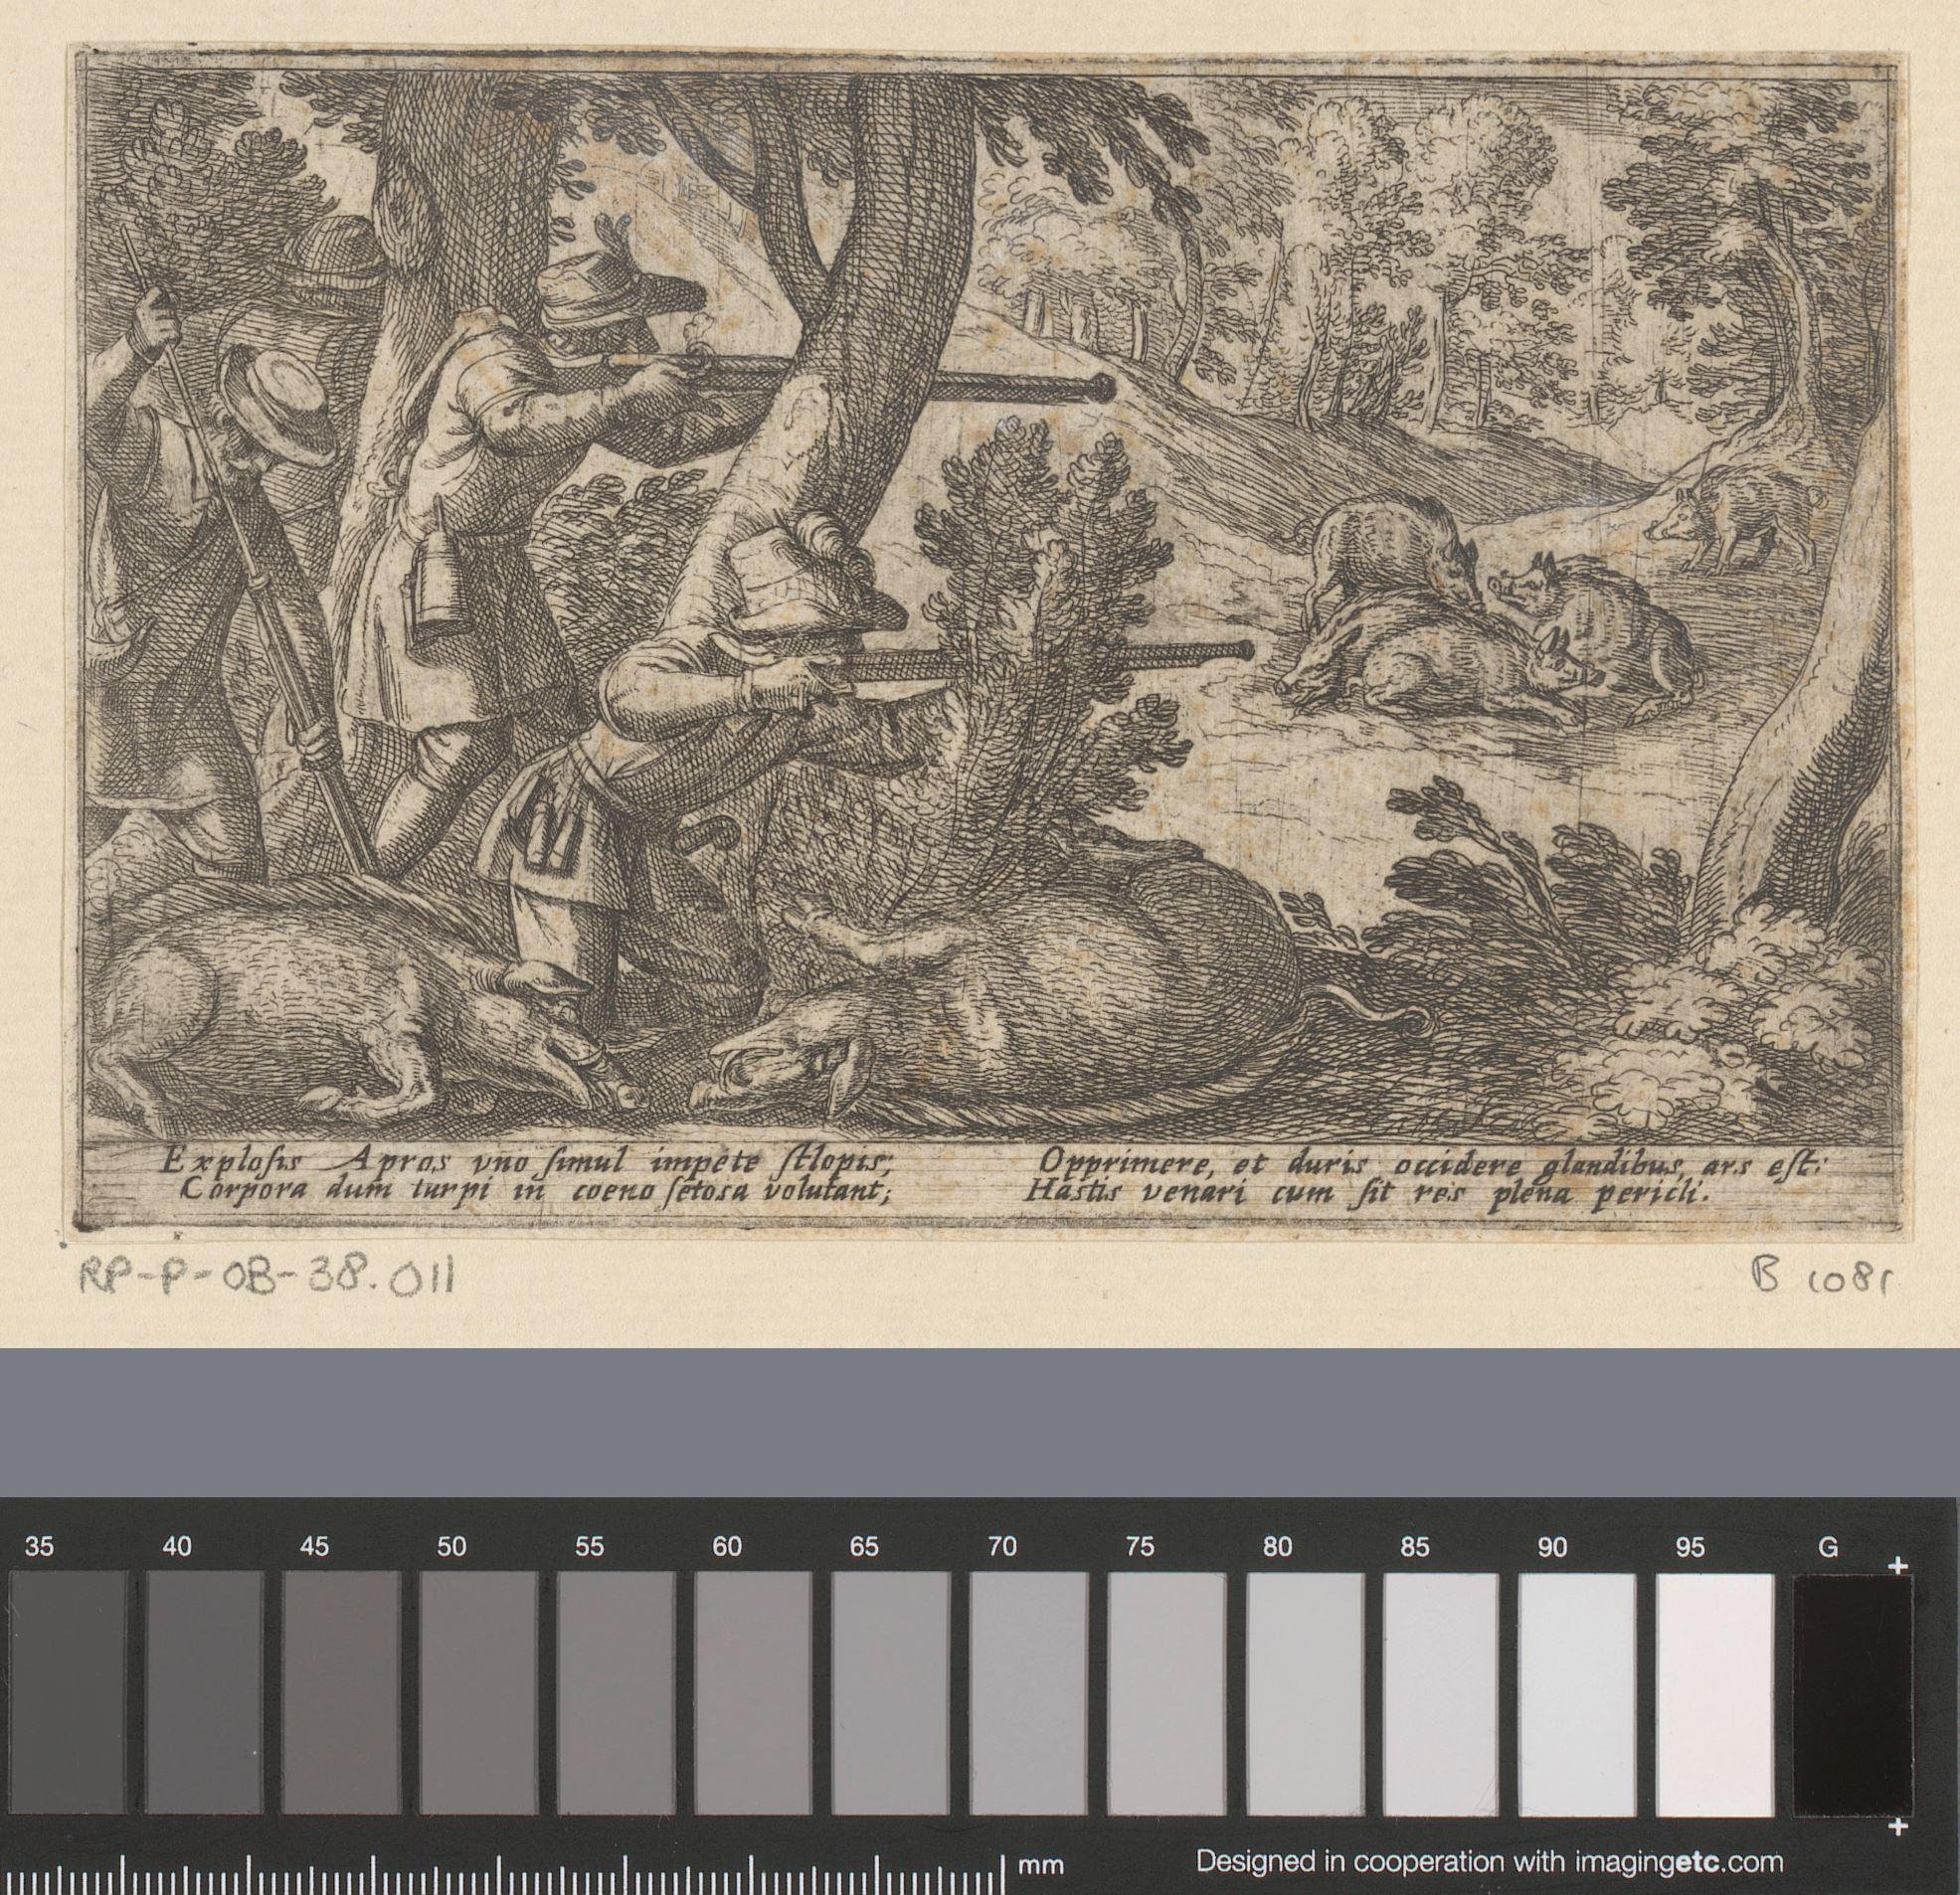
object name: print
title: Jagers schieten op wilde everzwijnen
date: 1602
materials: paper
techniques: etching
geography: italy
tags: boar-hunting, hunter, hunters hunting (n.b.: in 1988-1990 this notation denoted the concept of 43c11421 'hunters resting during the hunt')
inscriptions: collector's mark: Lugt 240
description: Landschap met jagers met geweren jagend op everzwijnen. Tekst in het Latijn in ondermarge.